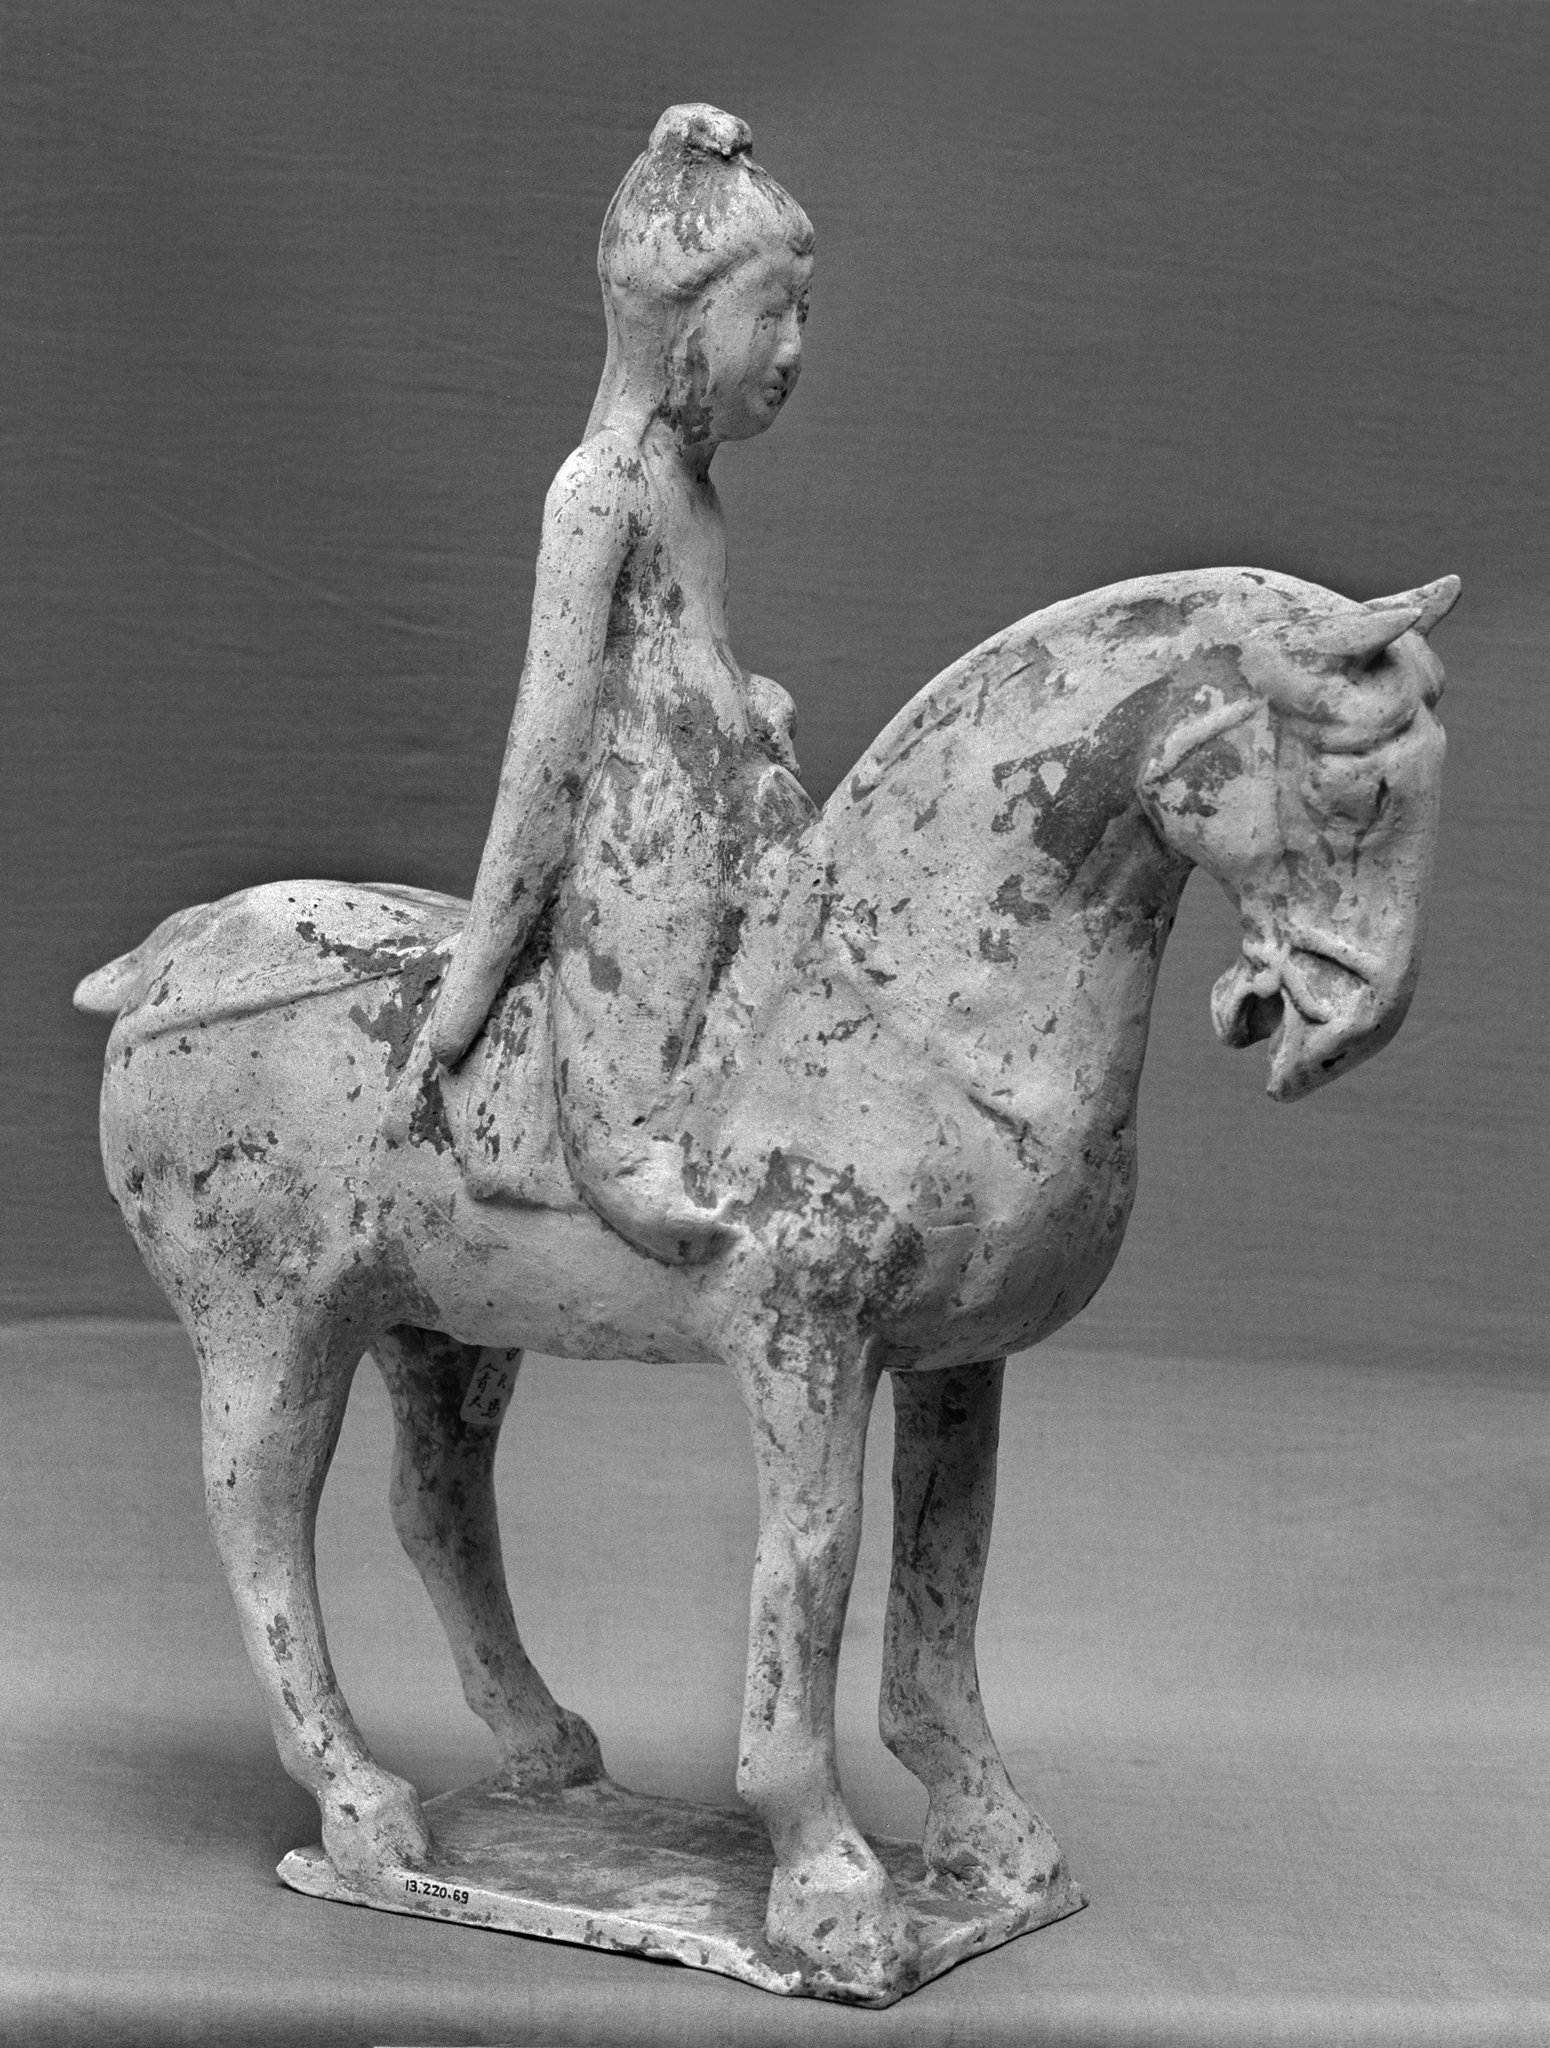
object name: figure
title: Horse and rider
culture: chinese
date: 601-800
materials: earthenware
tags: women,horses